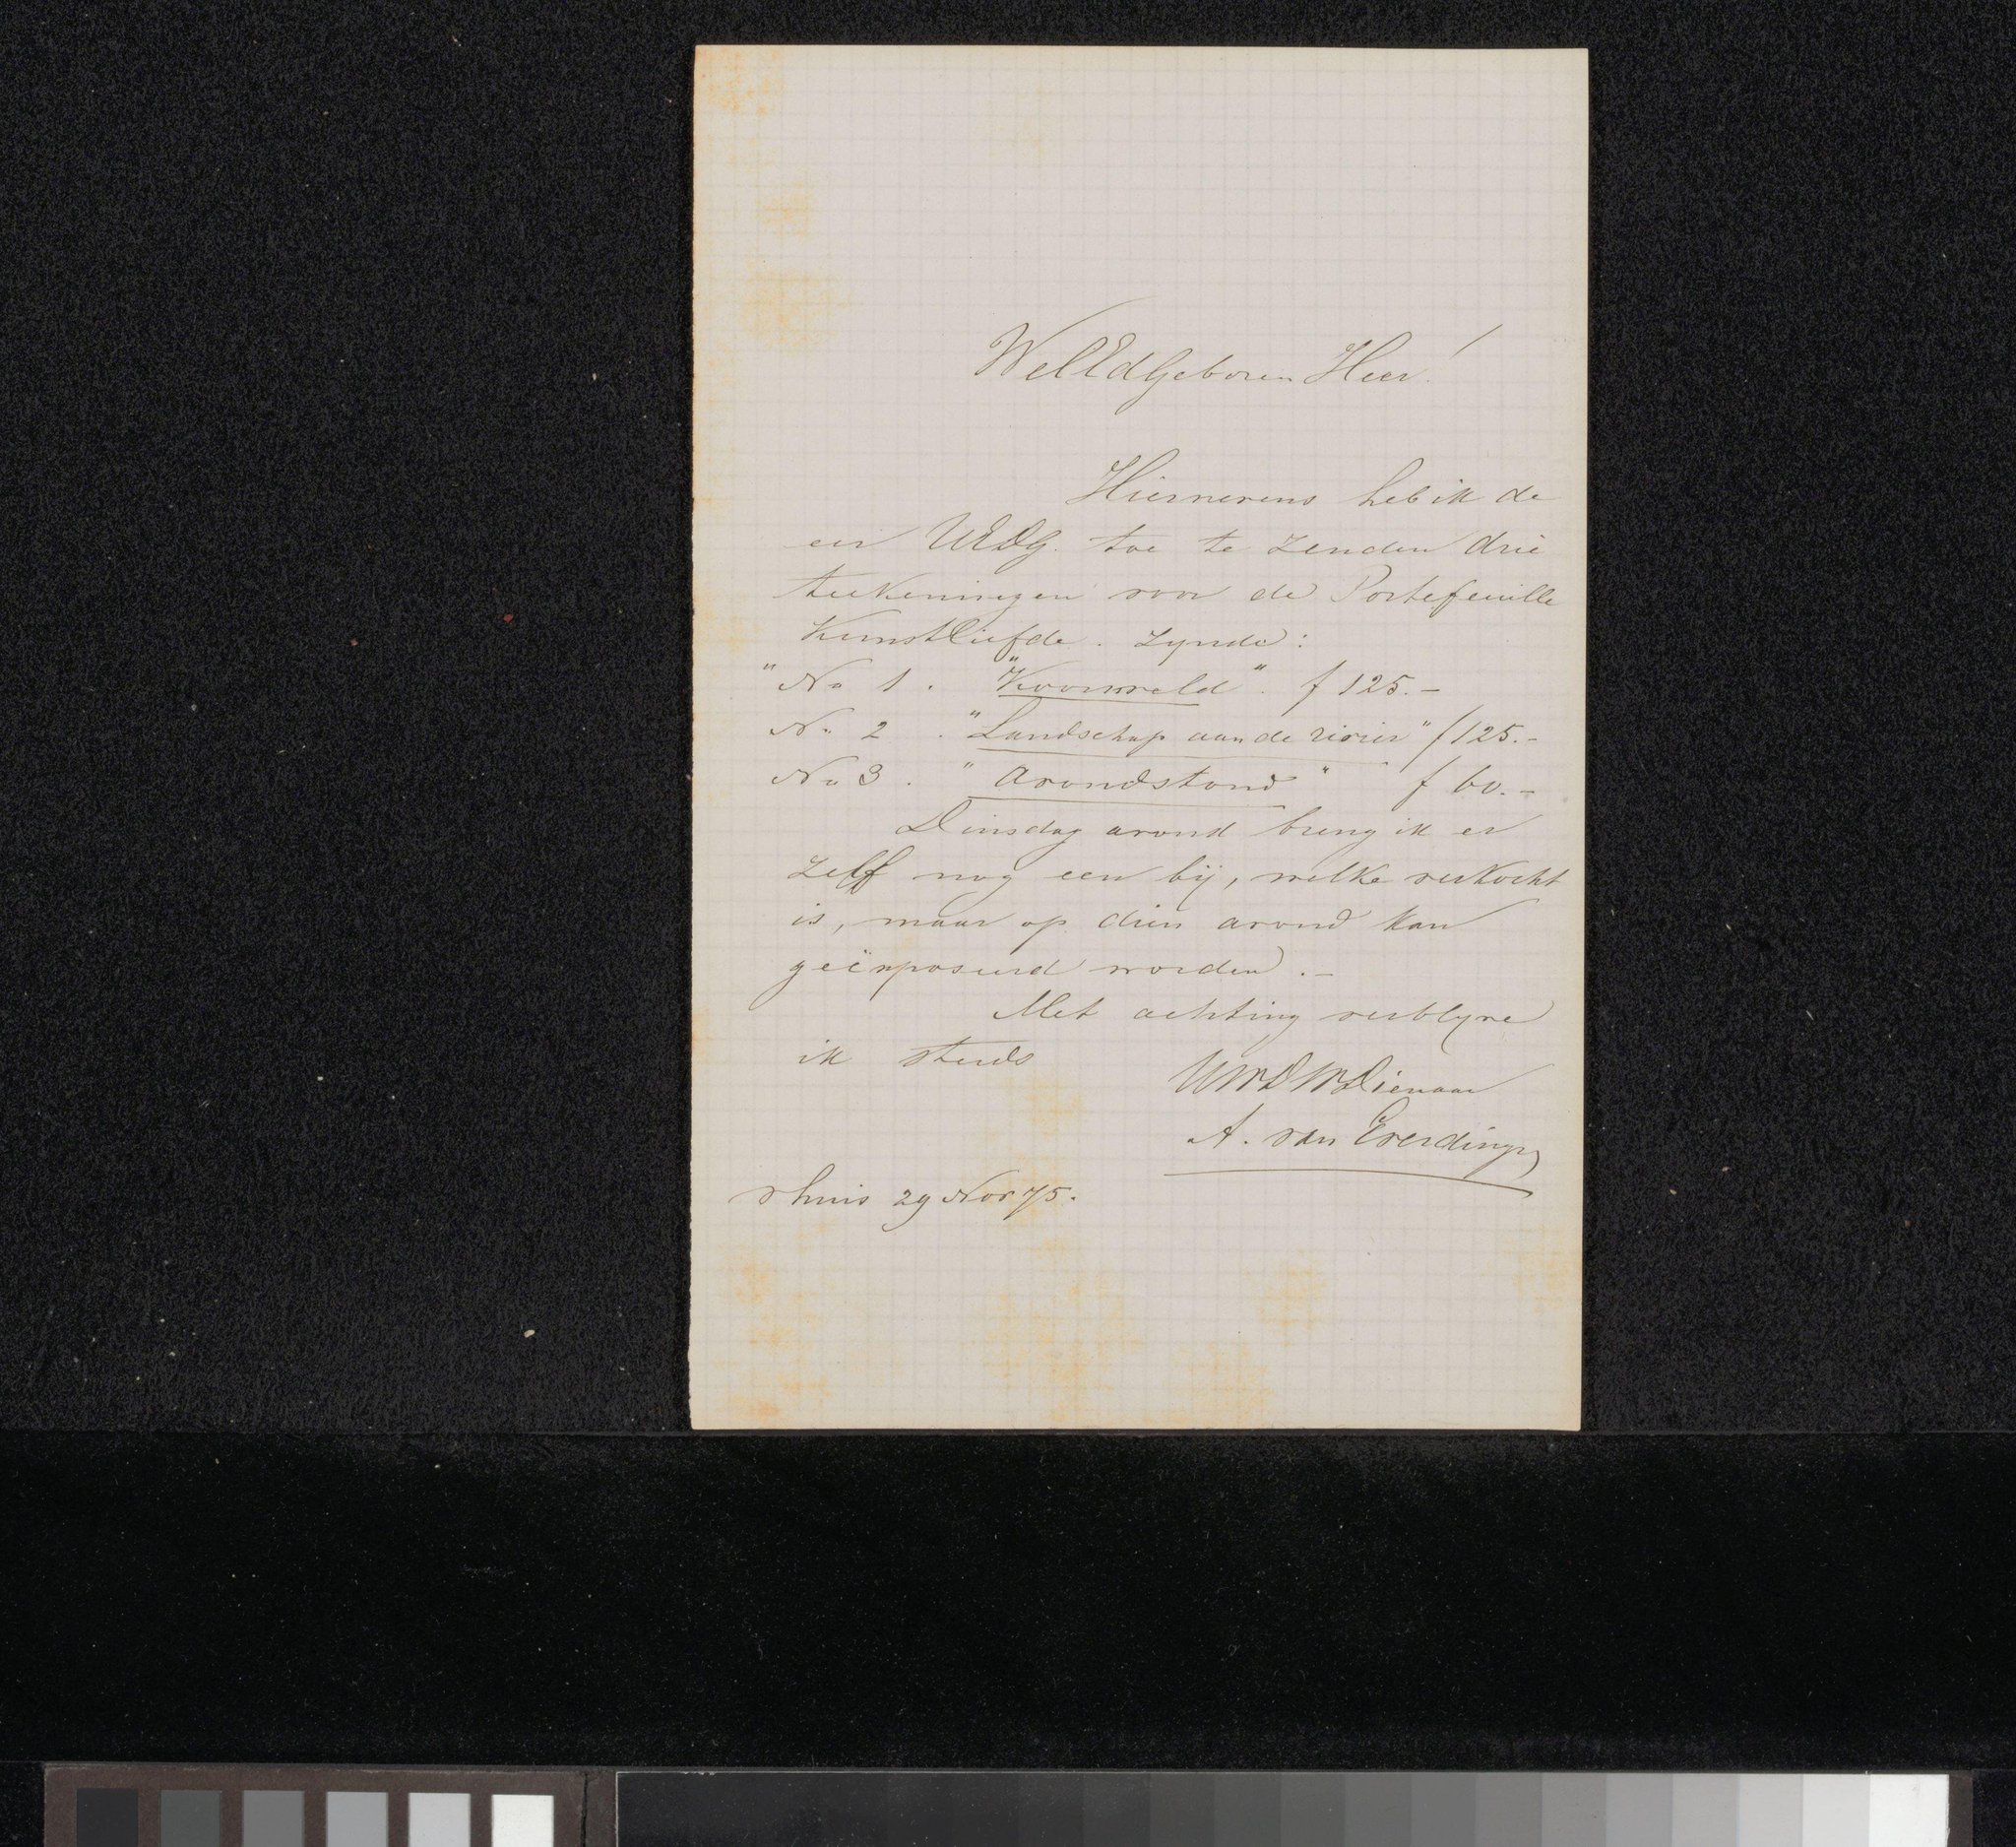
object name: letter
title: Brief aan Pieter Verloren van Themaat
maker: adrianus van everdingen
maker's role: print maker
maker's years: 1832-1912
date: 1875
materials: ink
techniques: pen, writing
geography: utrecht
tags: utrecht, pieter verloren van themaat, drawing, exhibition ~ art, money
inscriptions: collector's mark: ‘RPK’